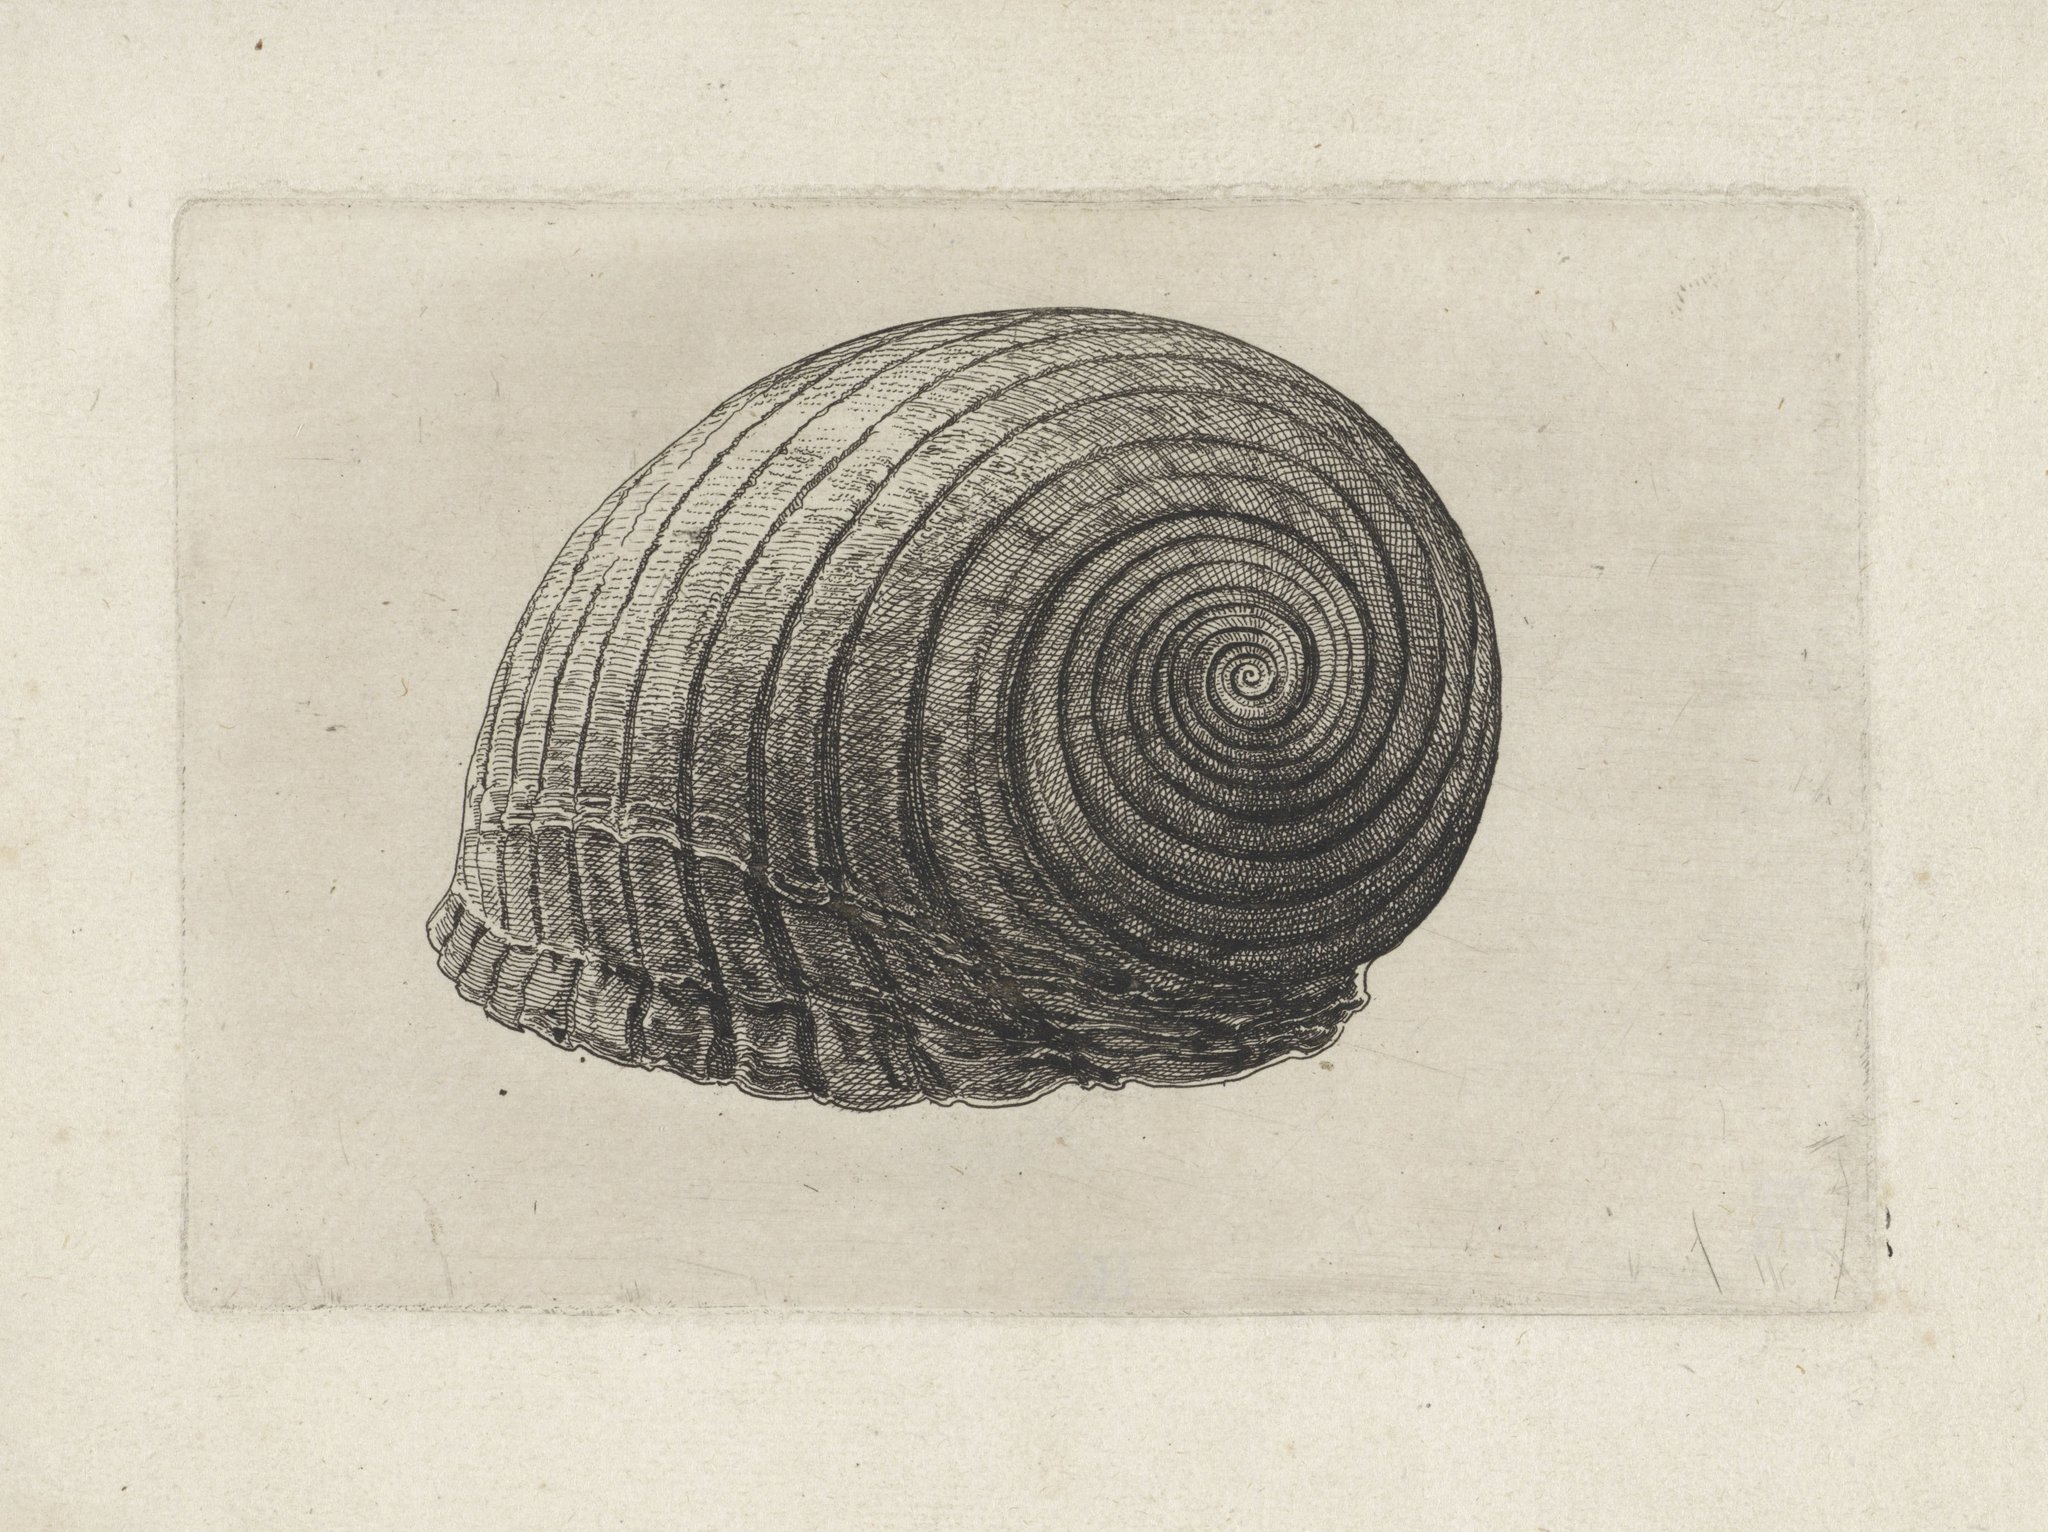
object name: print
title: Schelp, tonna galea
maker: wenceslaus hollar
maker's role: draughtsman, print maker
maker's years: 1607-1677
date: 1644-1652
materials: paper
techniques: etching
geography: antwerp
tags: molluscs (+ shell, snail-shell etc.)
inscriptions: collector's mark: Lugt 654, collector's mark: Lugt 68, collector's mark: Lugt 384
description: Prent maakt deel uit van een 39-delige serie met verschillende soorten schelpen.